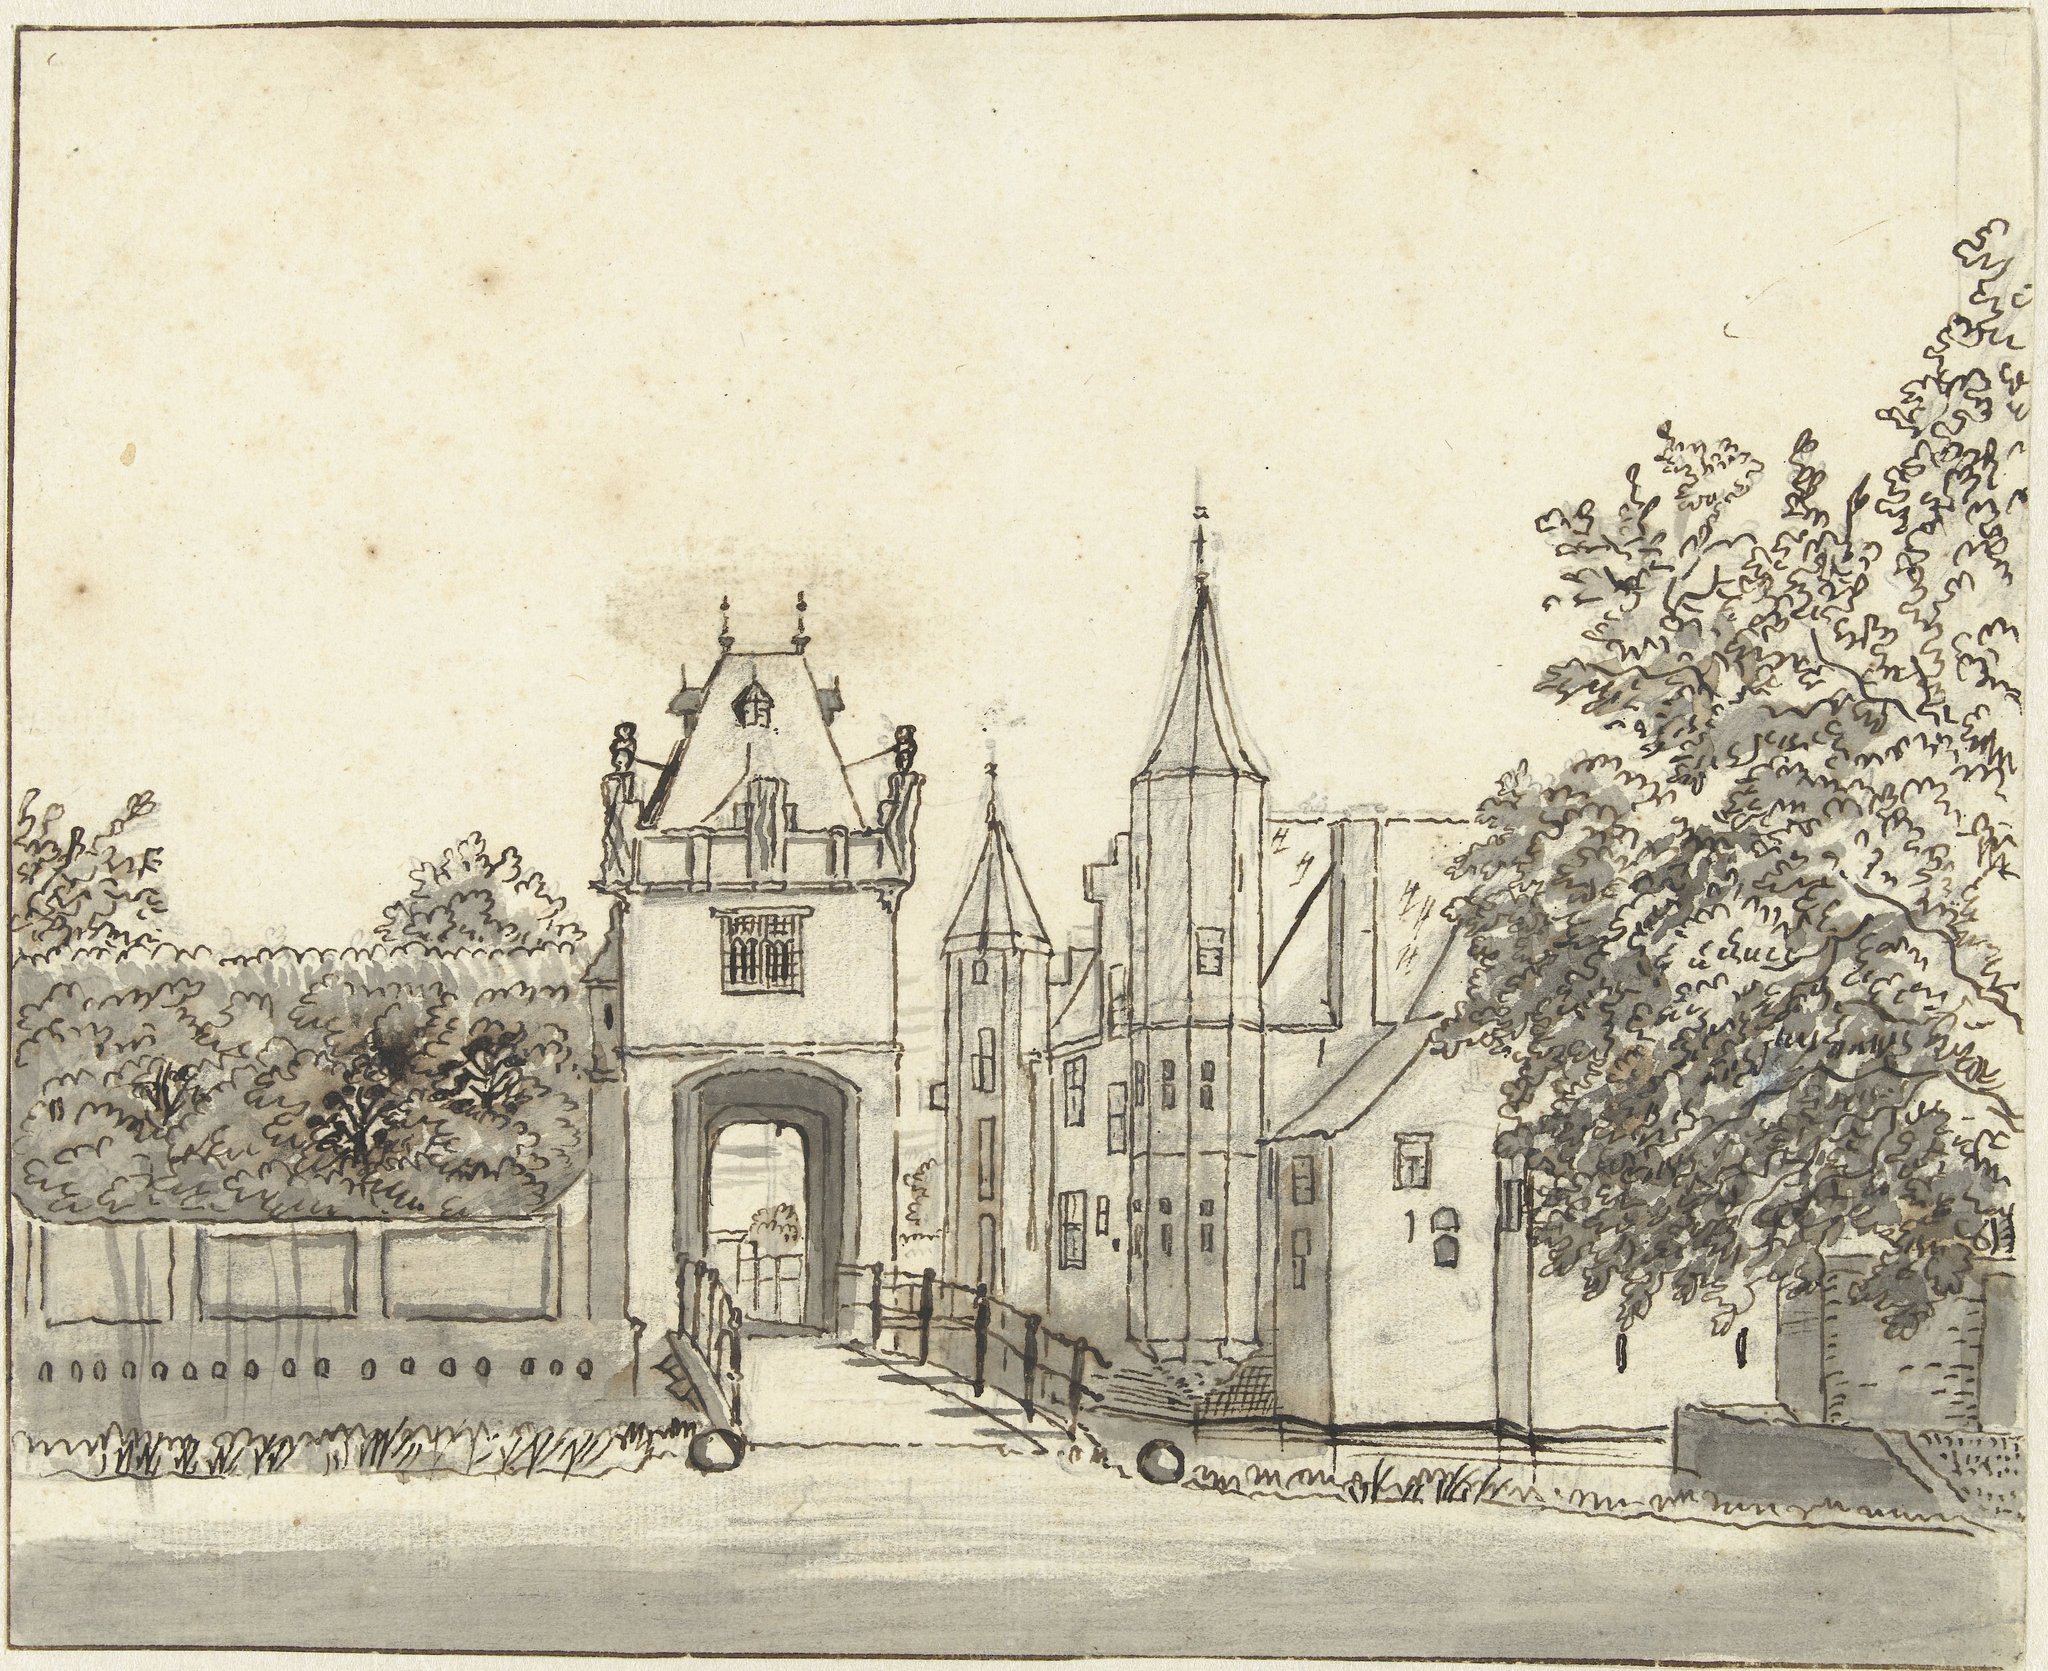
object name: drawing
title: Het Huis te Zuylen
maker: jacob van liender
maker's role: draughtsman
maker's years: 1696-1759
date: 1706-1759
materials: ink, paper, pencil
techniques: brush, pen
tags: castle